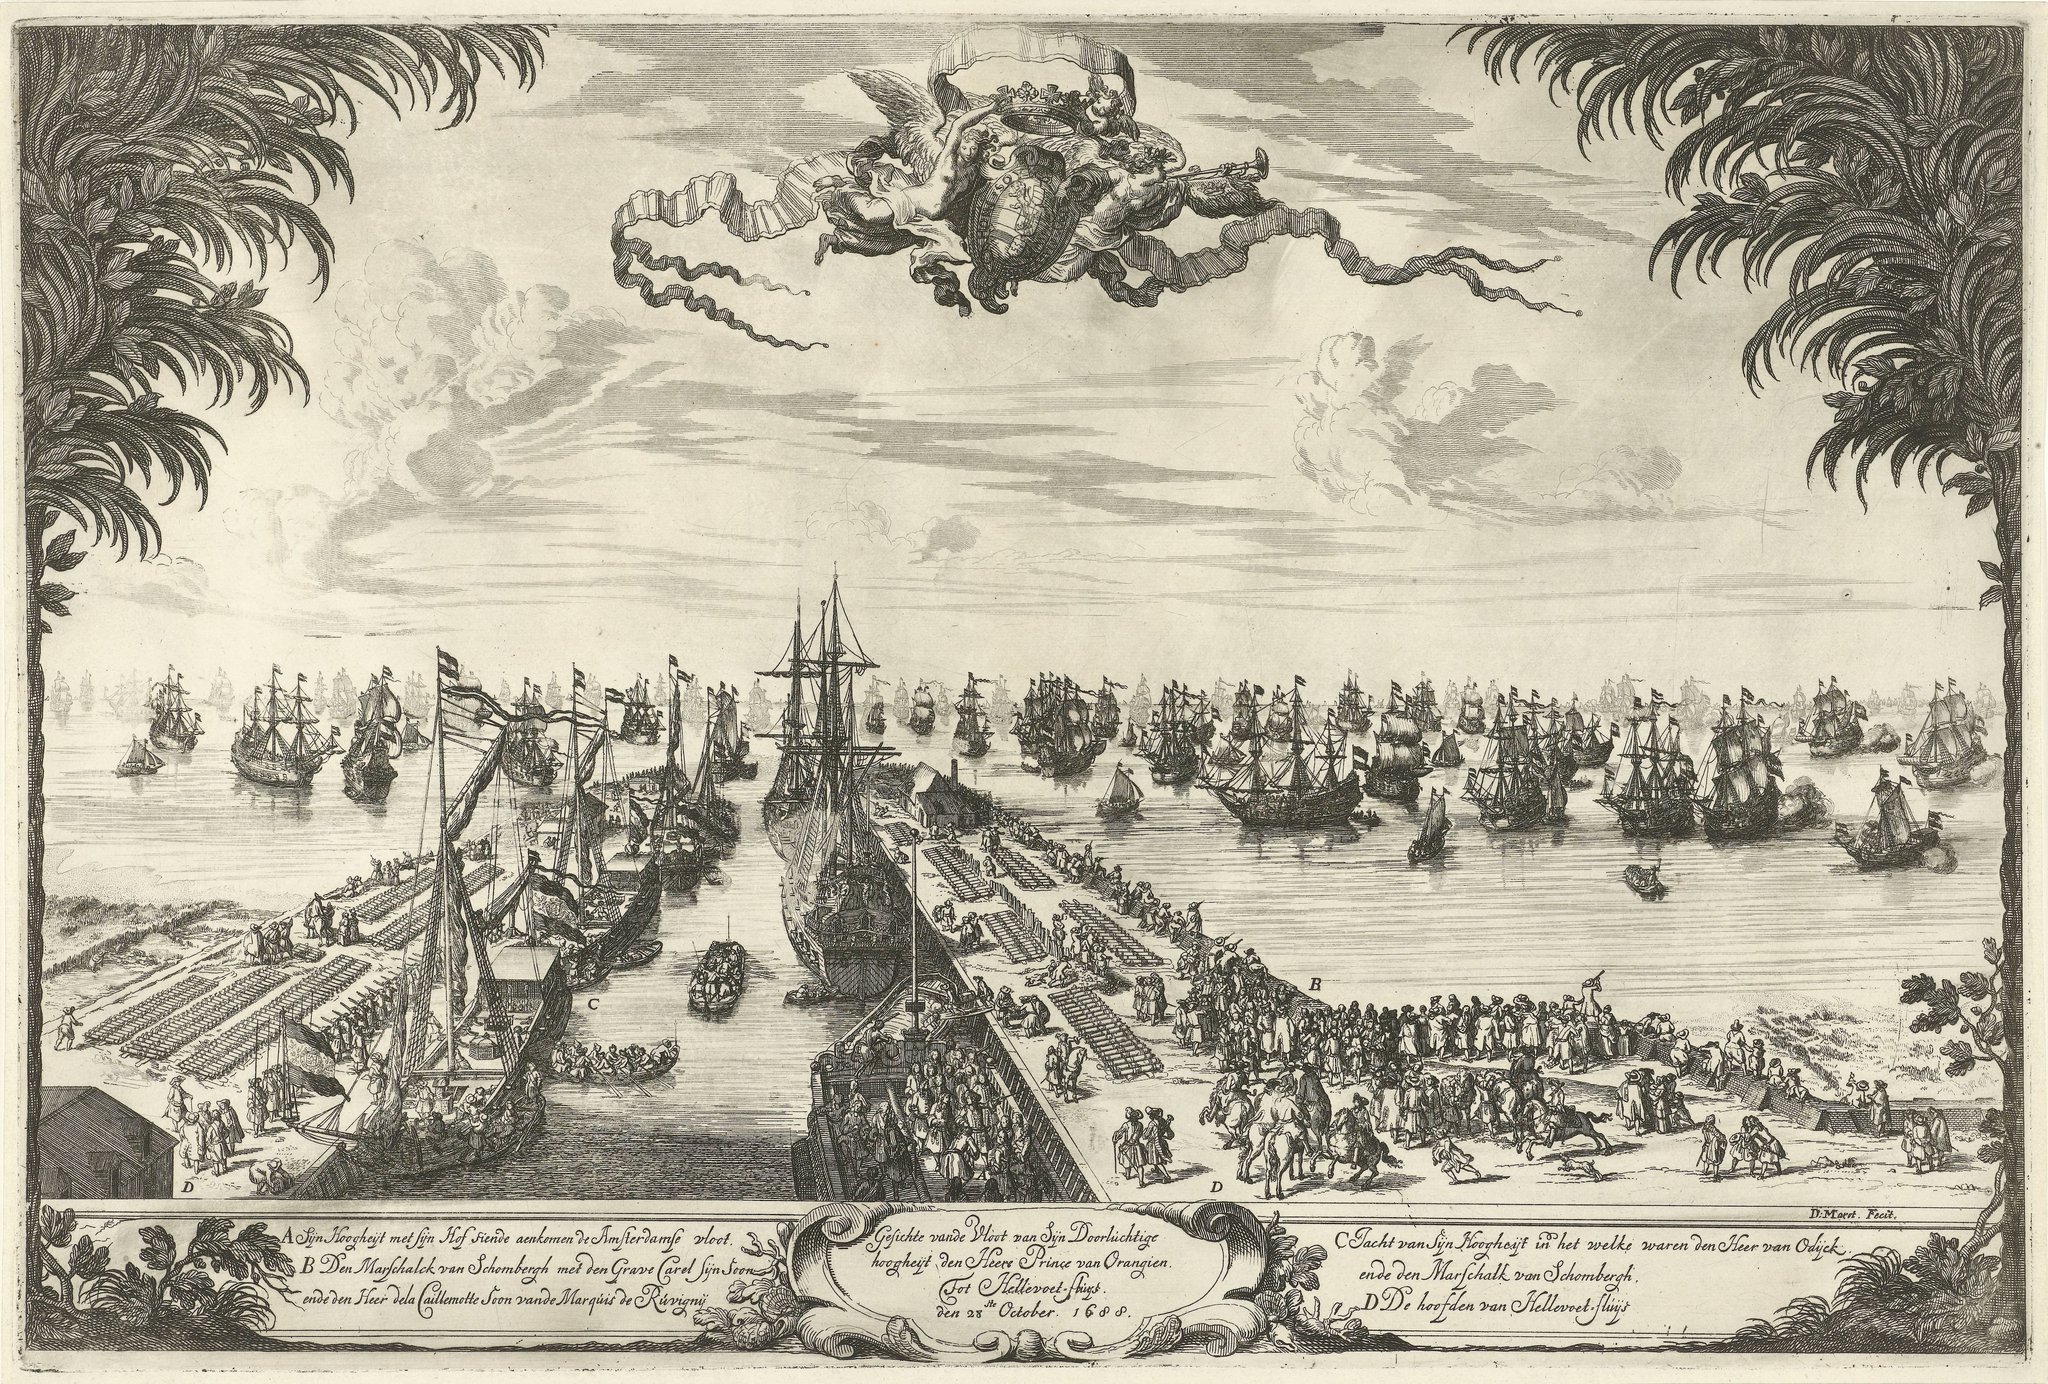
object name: print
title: Gesichte van de vloot van Sijn Doorluchtige hoogheijt den Heere Prince van Orangien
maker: daniël marot (i)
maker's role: draughtsman, print maker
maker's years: 1661-1752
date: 1688-1700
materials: paper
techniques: etching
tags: william iii (prince of orange and king of england, scotland, and ireland), firearms: cannon, ships (in general) - cc - more than one ship, pier, quay, wharf, departure ~ travelling, hellevoetsluis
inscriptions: collector's mark: Lugt 2228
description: De voot van Willem III liggende te Hellevoetsluis op 28 oktober 1688, voor het vertrek naar Engeland op 11 novenber 1688. De vloot wordt in de haven van Hellevoetsluis in gereedheid gebracht voor de tocht van prins Willem III met zijn leger naar Engeland. Een panormabeeld van de vloot van Stadhouder Willem III, met een uitleg in een kader onderin (waar ook de titel).